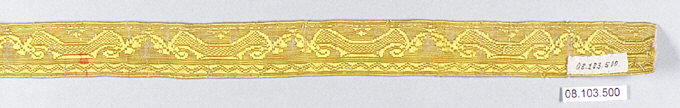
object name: galloon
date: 1701-1800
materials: cotton, silk